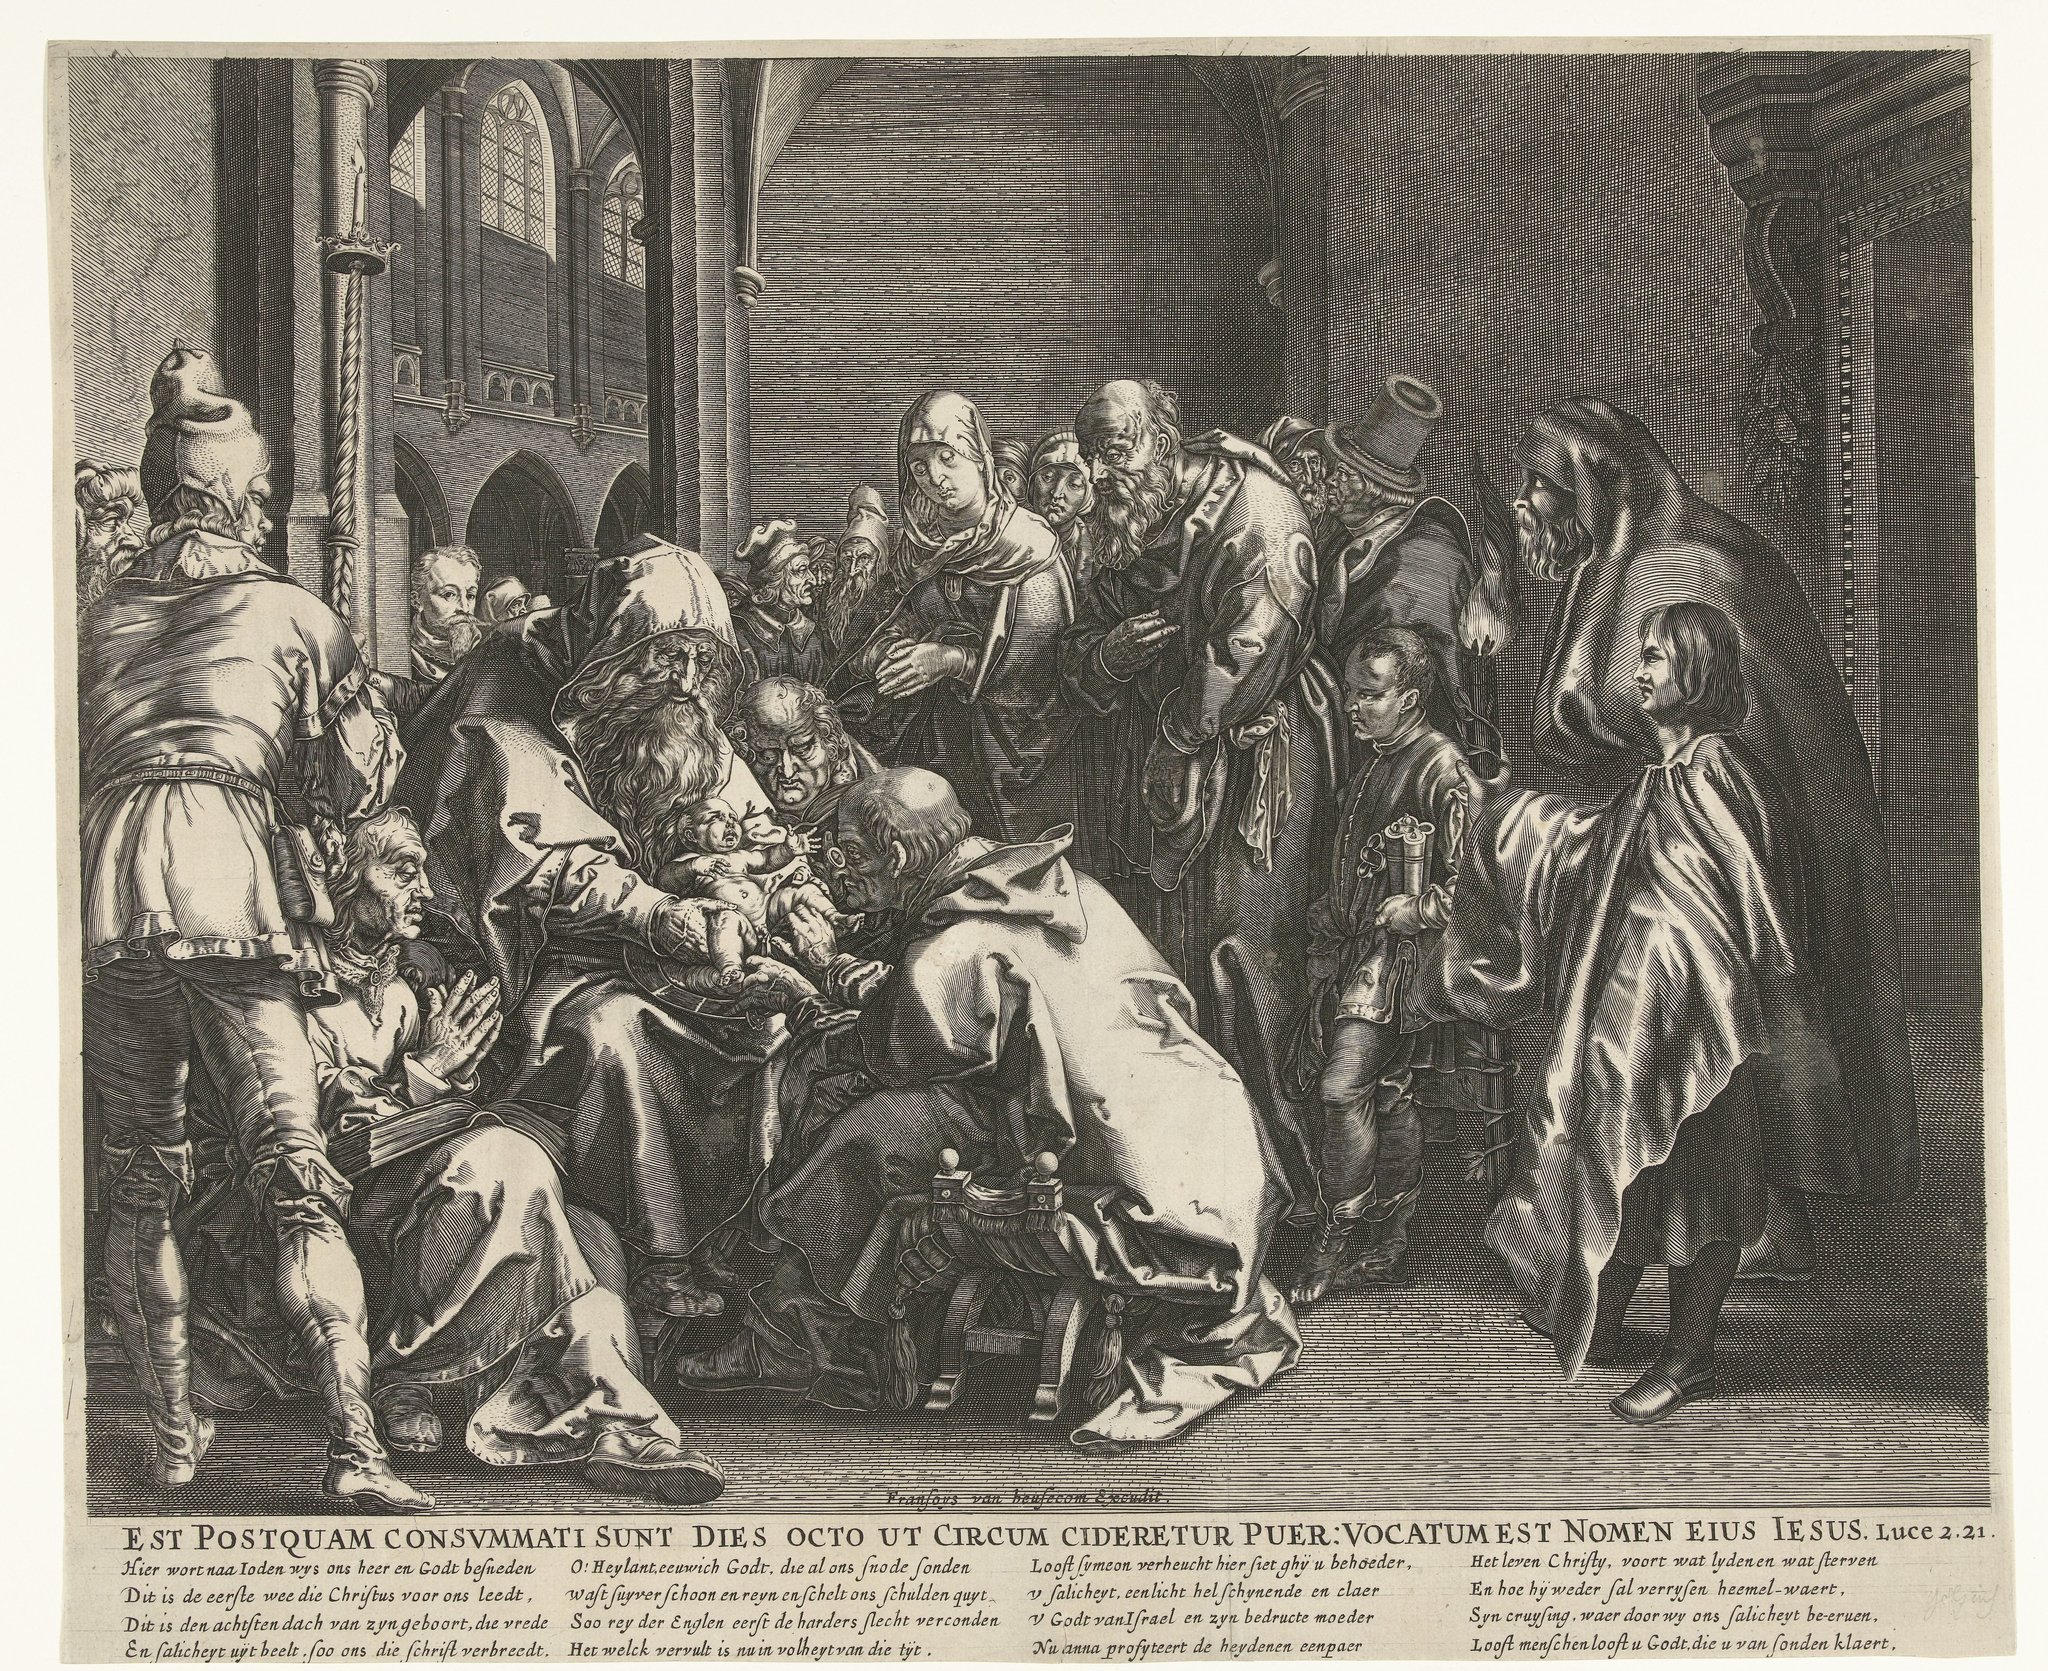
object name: print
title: De besnijdenis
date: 1642-1665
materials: paper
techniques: engraving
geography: amsterdam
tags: circumcision of the christ-child by the priest in the temple (luke 2:21)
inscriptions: collector's mark: Lugt 2228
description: Het Christuskind wordt besneden in een kapel in een grote kerk. Veel omstanders kijken toe. Onder de voorstelling een vers uit Lucas 2.21 in het Latijn en een gedicht in vier coupletten van elk vier regels in het Nederlands.